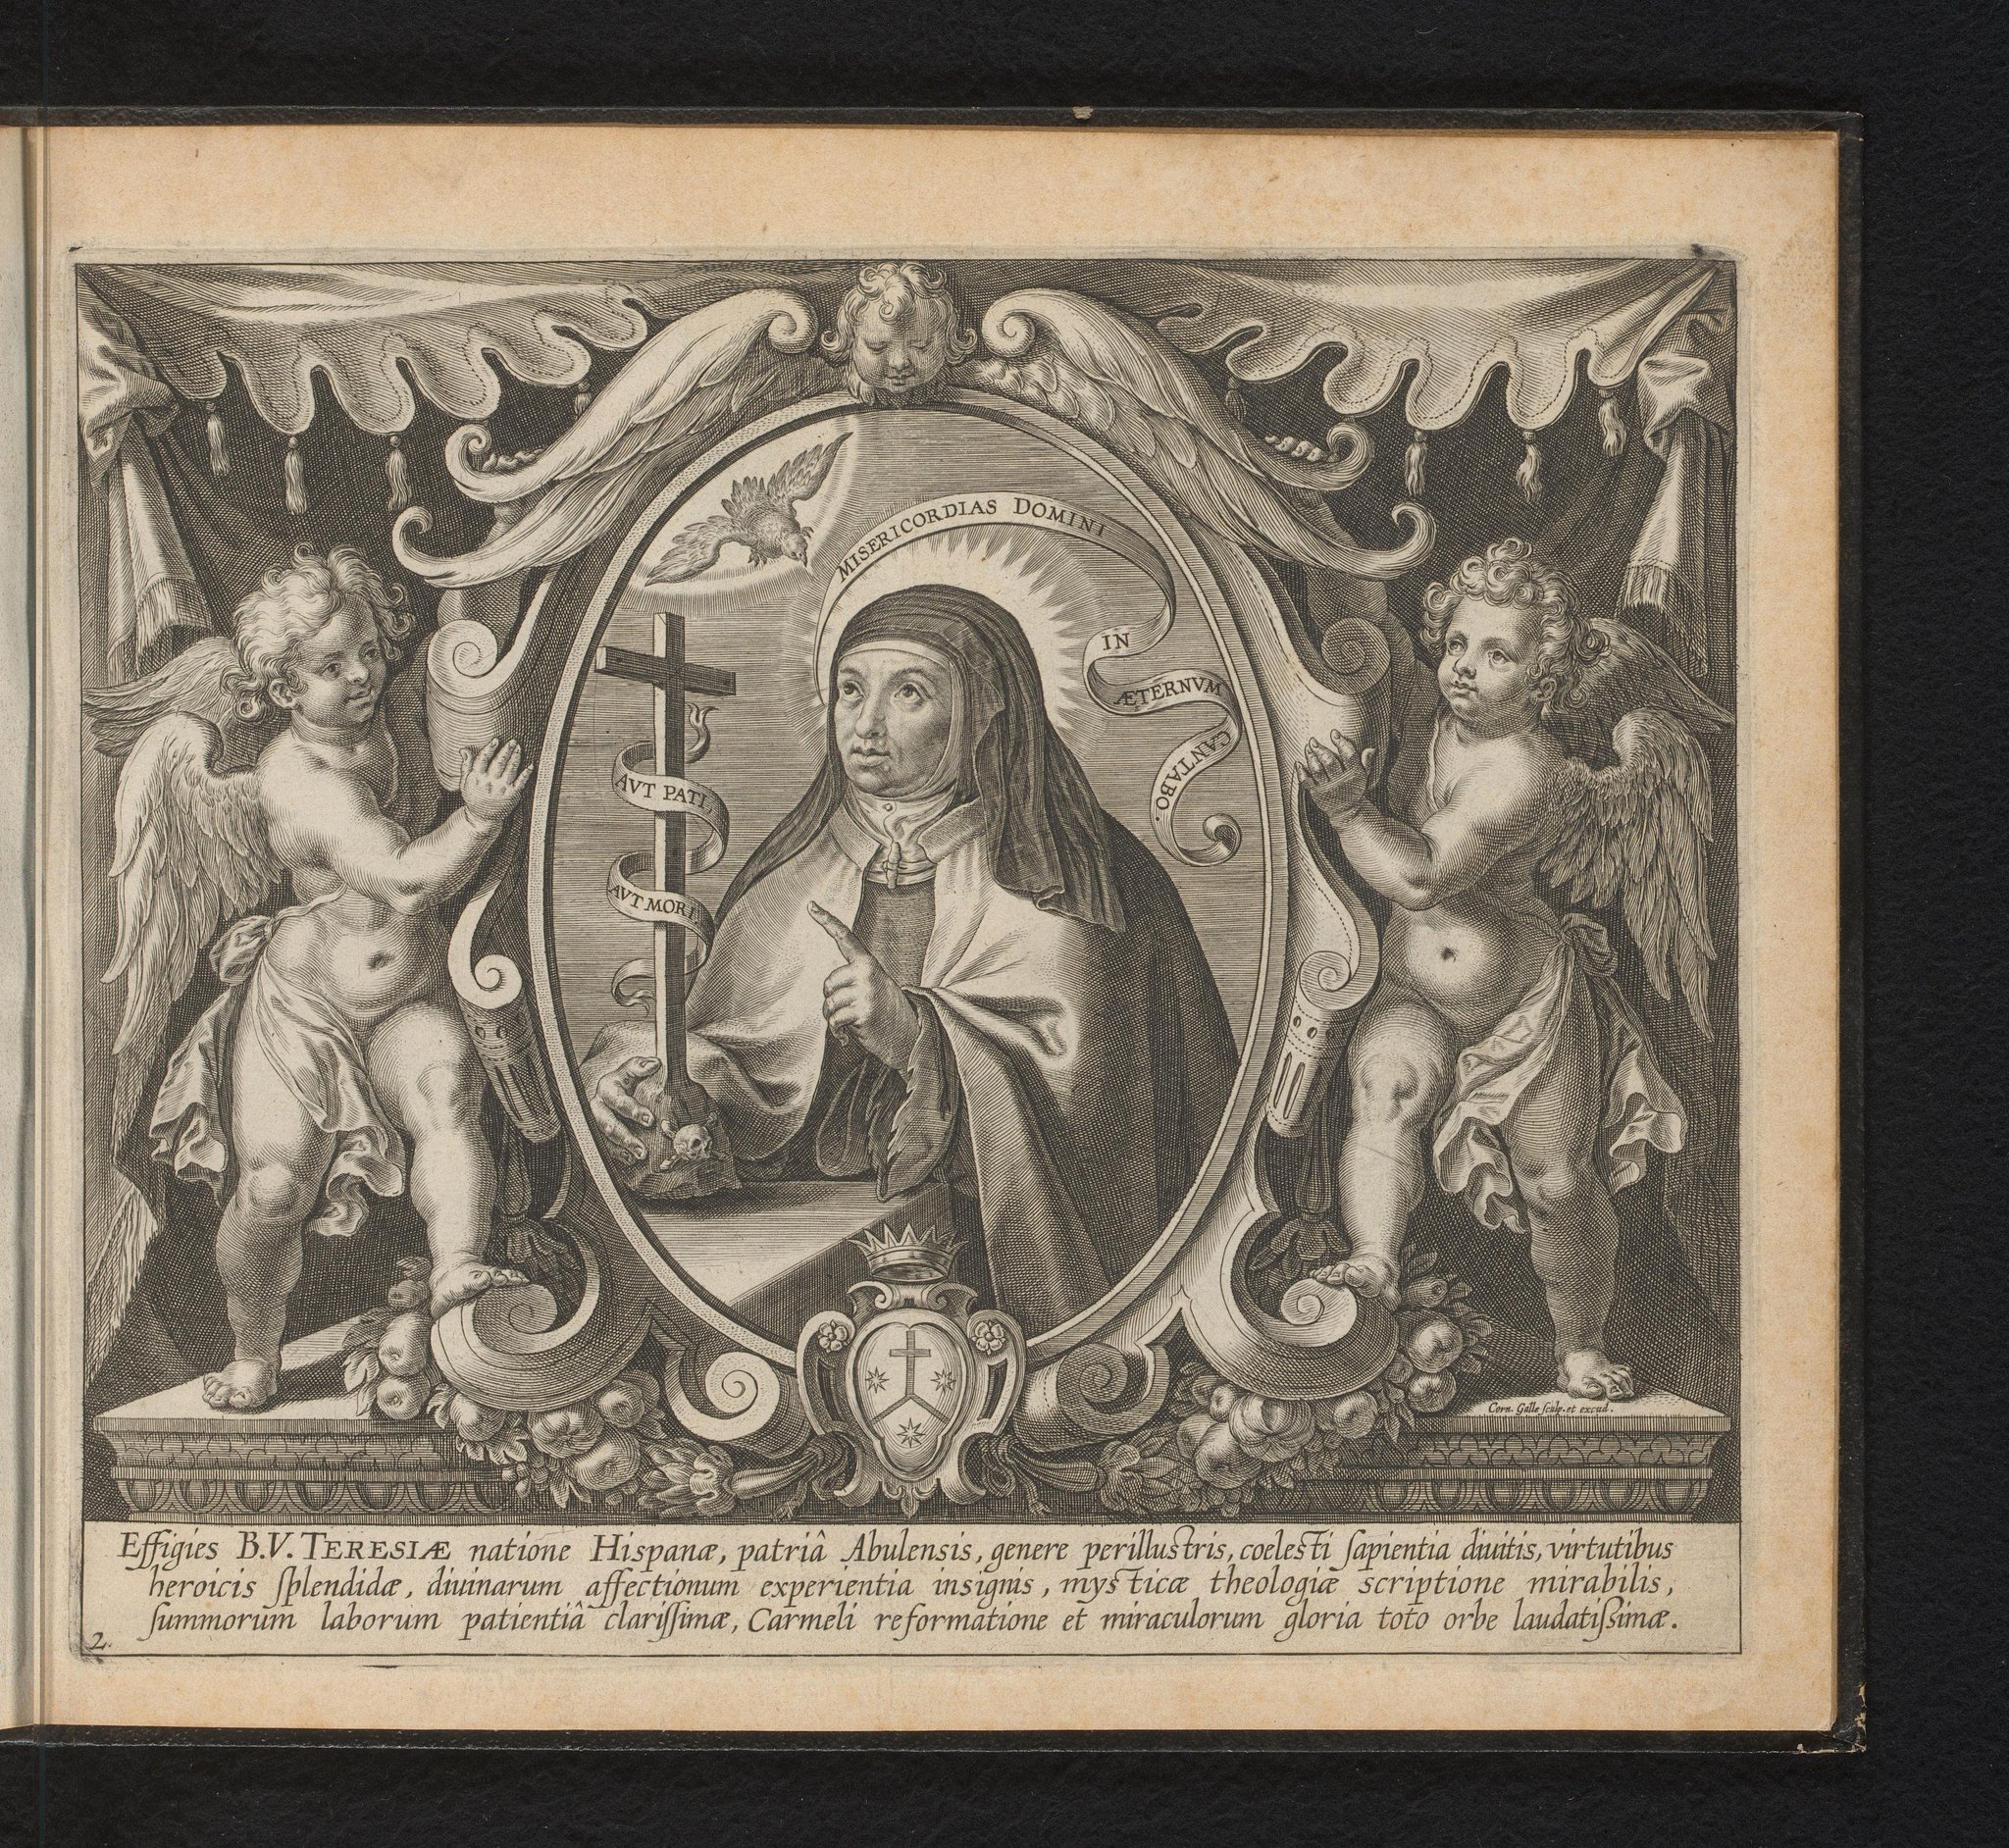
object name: print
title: Portret van de H. Theresa van Avila, met twee engelen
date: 1613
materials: paper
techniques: engraving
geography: antwerp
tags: the foundress of the reformed (discalced) carmelites, t(h)eres(i)a of avila; possible attributes: angel, arrow, dove, heart (flaming or pierced by an arrow)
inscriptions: number: ‘2’, signature and address: ‘Corn. Galle sculp et excud.’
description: Portret van de H. Theresia, kijkend naar crucifix voor haar. De H. Geest in de vorm van een duif boven haar hoofd. Het portret wordt vastgehouden door twee engelen. Onder draperie. Met onderschrift in Latijn. Prent in album 'Vita B. Virginis Teresiae A. Jesu ordinis carmelitarum excalceatorum piae restauratricis..., 1613.